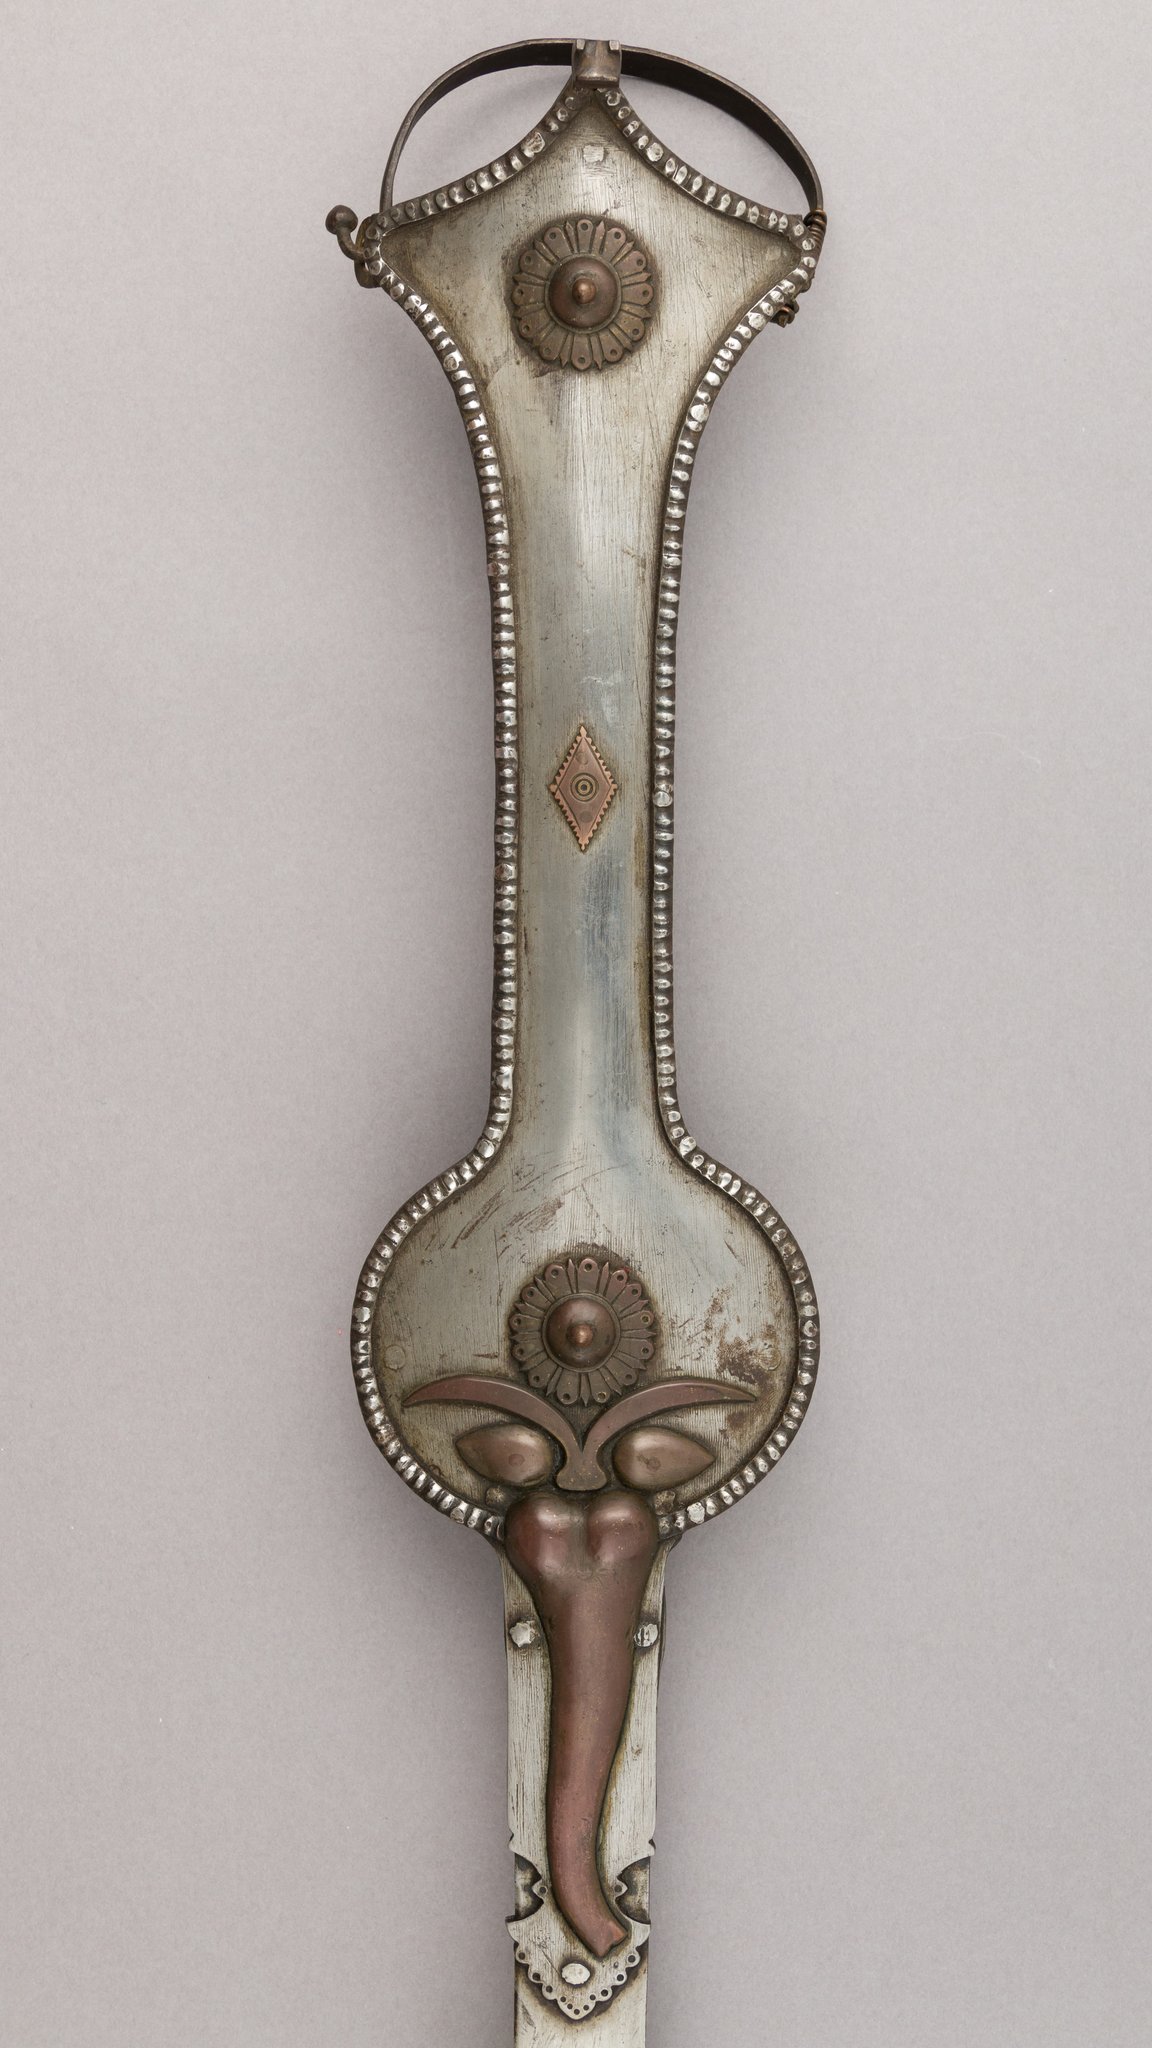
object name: gauntlet sword pata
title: Gauntlet Sword (Pata)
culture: indian, south indian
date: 1701-1800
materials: brass, steel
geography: india